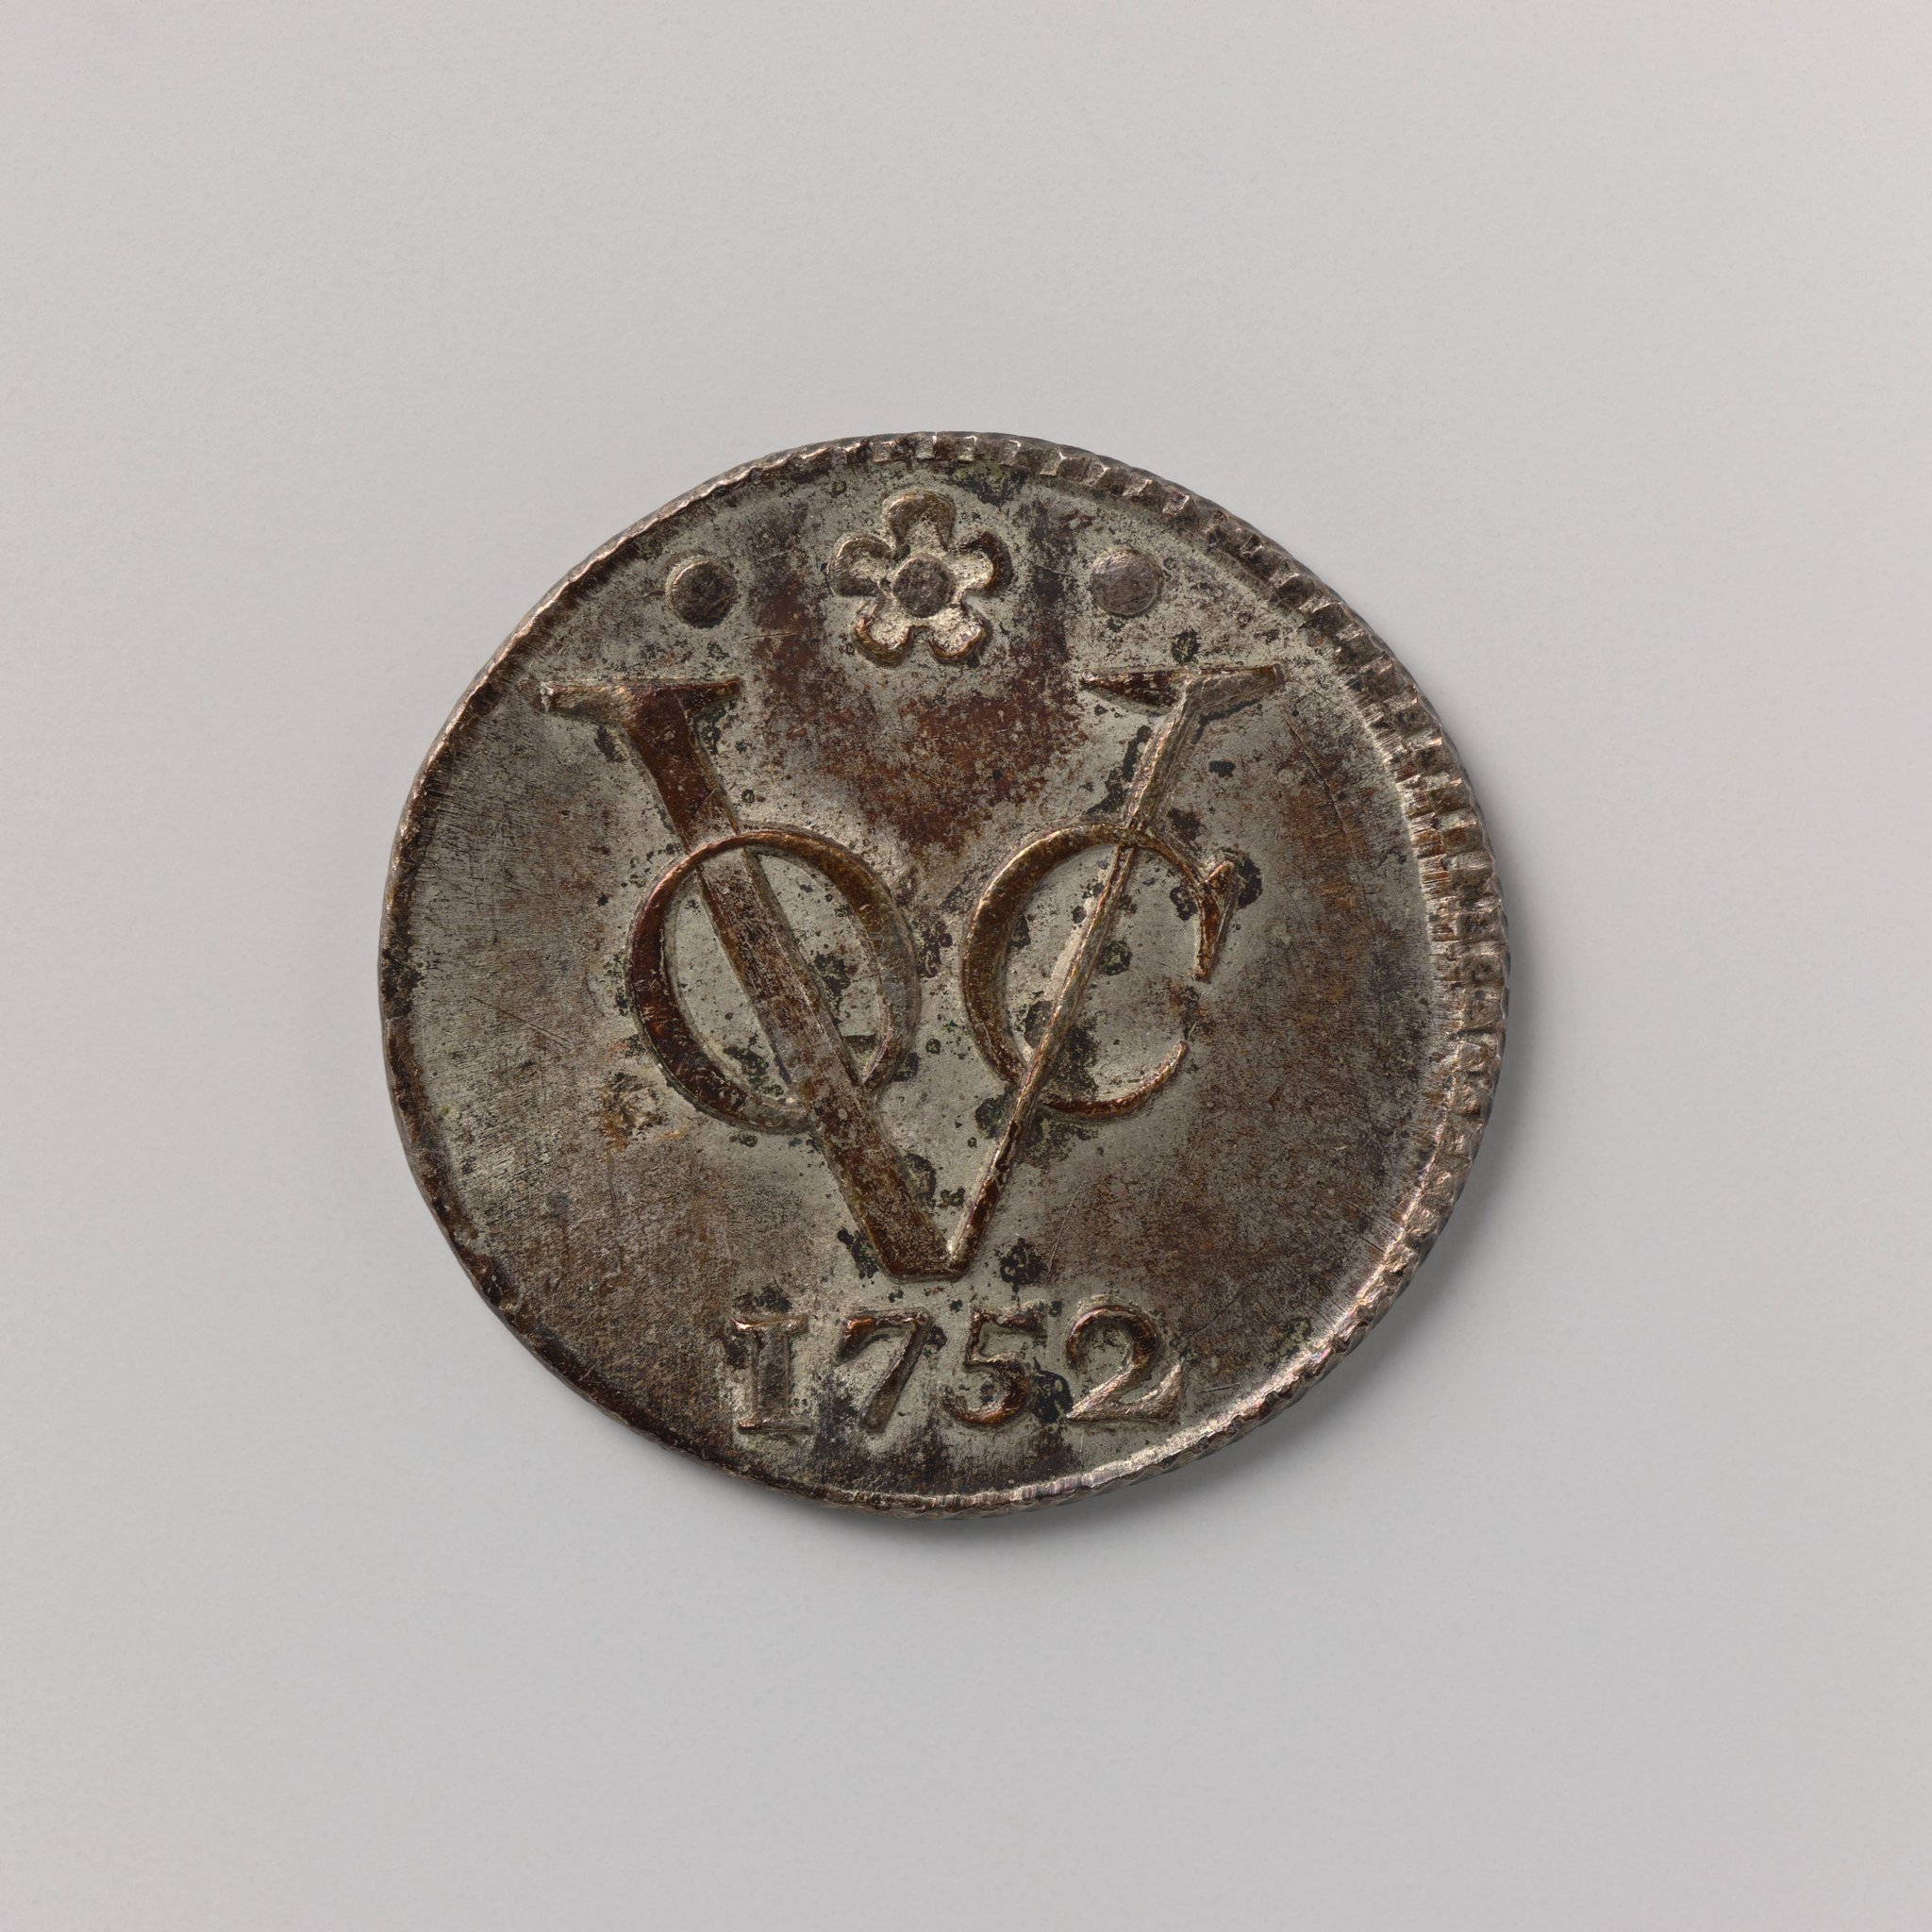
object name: coin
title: VOC, duit Holland, 1752, afslag in zilver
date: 1752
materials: silver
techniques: striking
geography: dordrecht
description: Zilveren munt. Voorzijde: gekroond wapenschild van Holland. Keerzijde: monogram van de VOC, waarboven muntteken en waaronder jaartal. Kabelrand. Afslag in zilver.